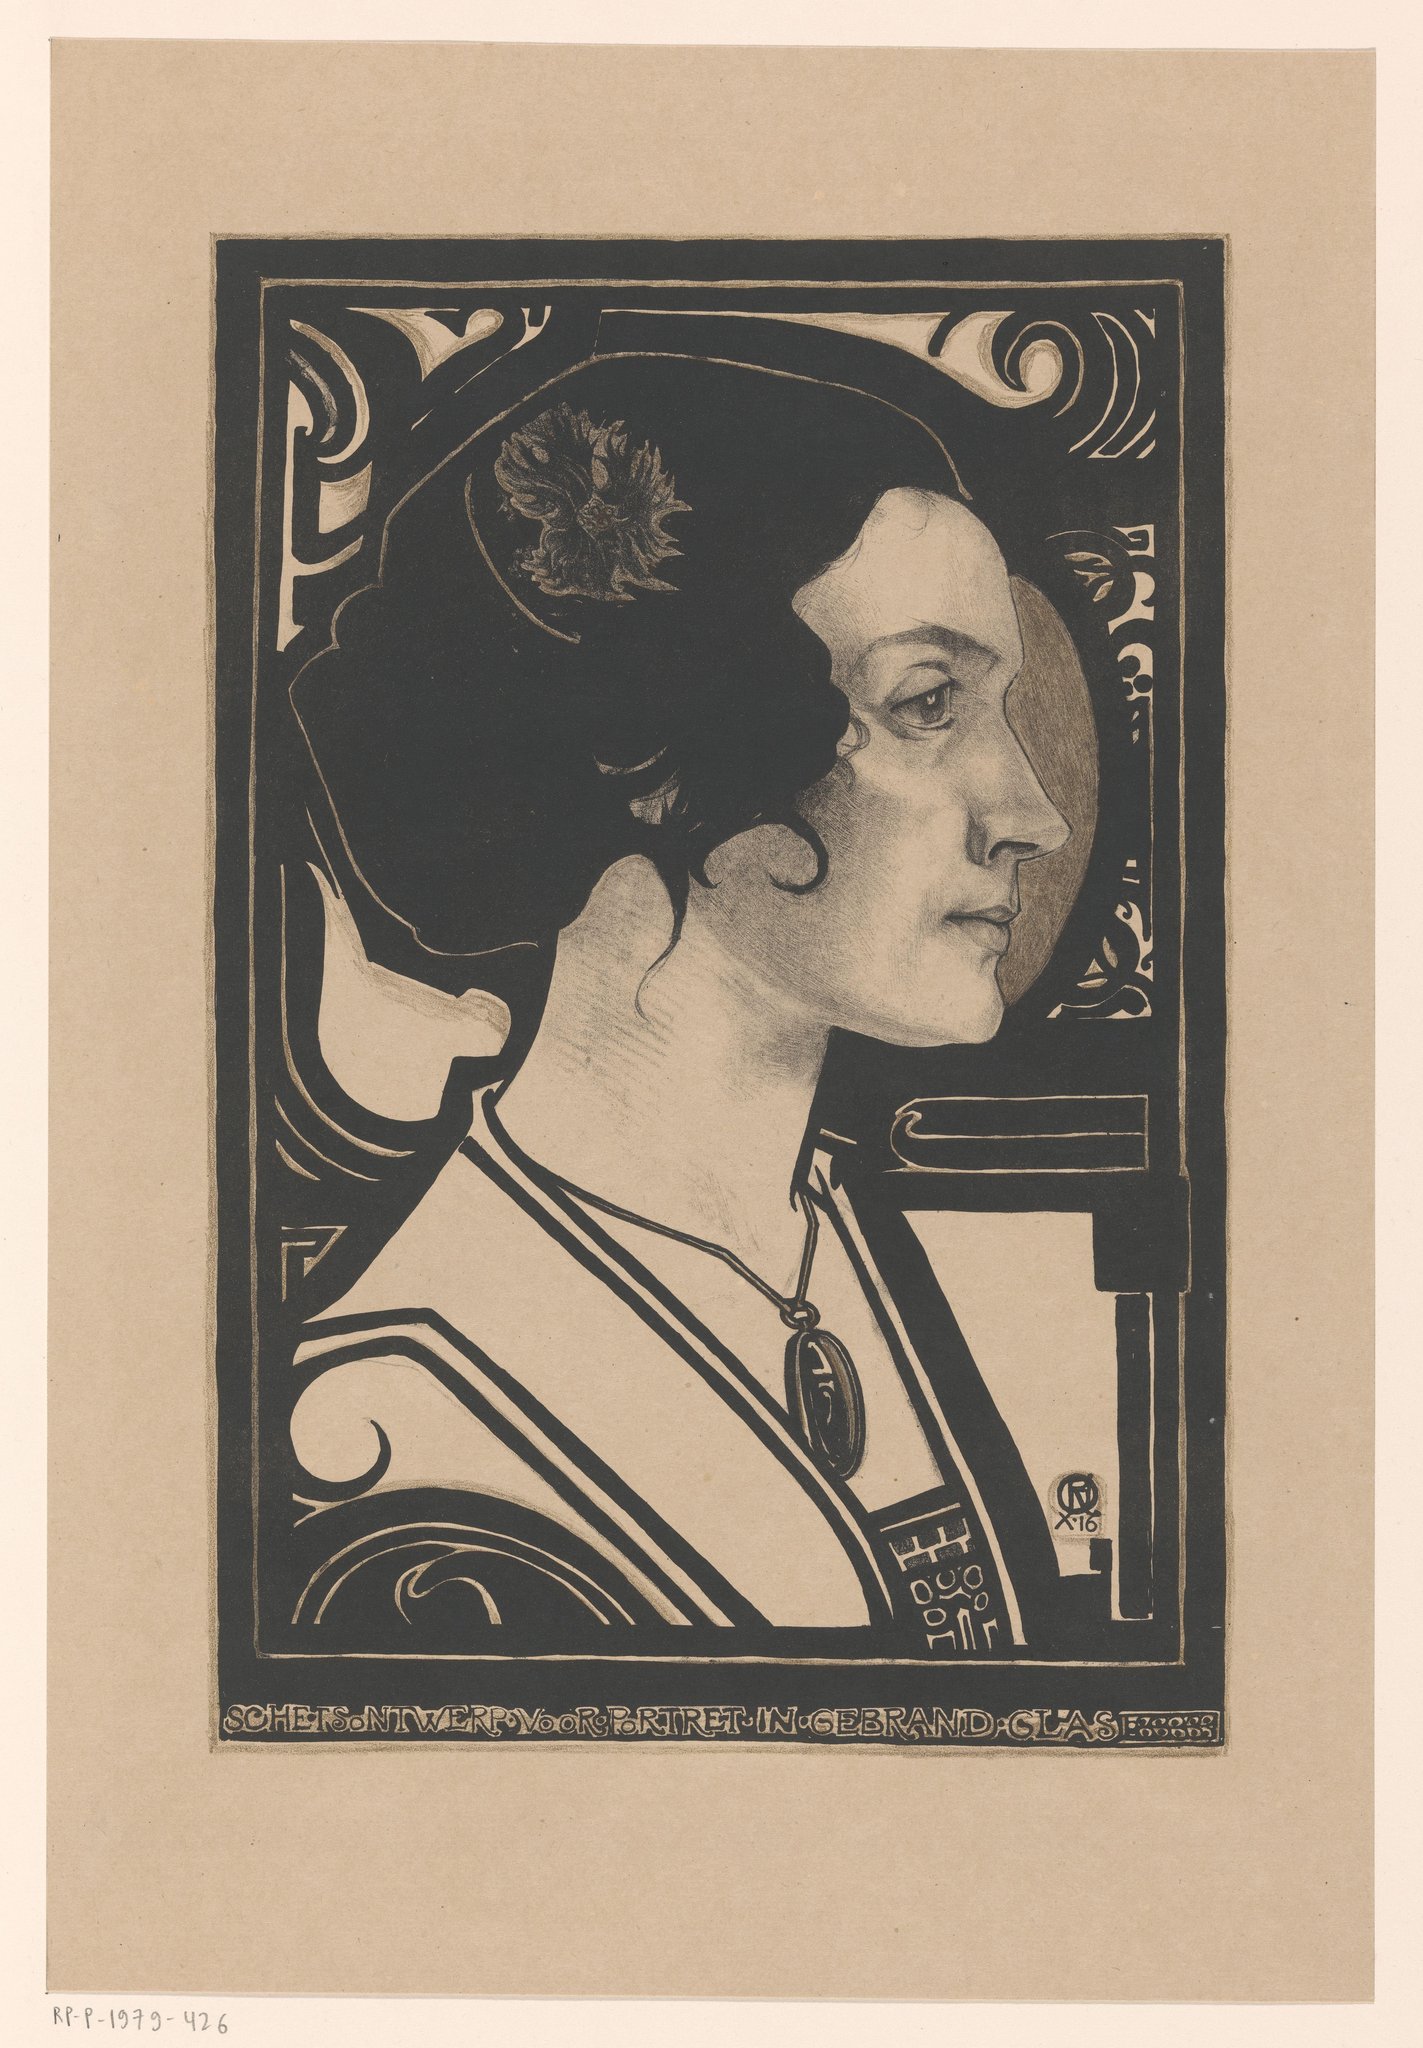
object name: print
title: Schetsontwerp voor portret in gebrand glas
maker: richard nicolaüs roland holst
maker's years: 1868-1938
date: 1910-1916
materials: paper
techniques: lithograph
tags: anonymous historical person portrayed - bb - woman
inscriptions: collector's mark: Lugt 2228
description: Een vrouw met opgestoken haar en een ketting.